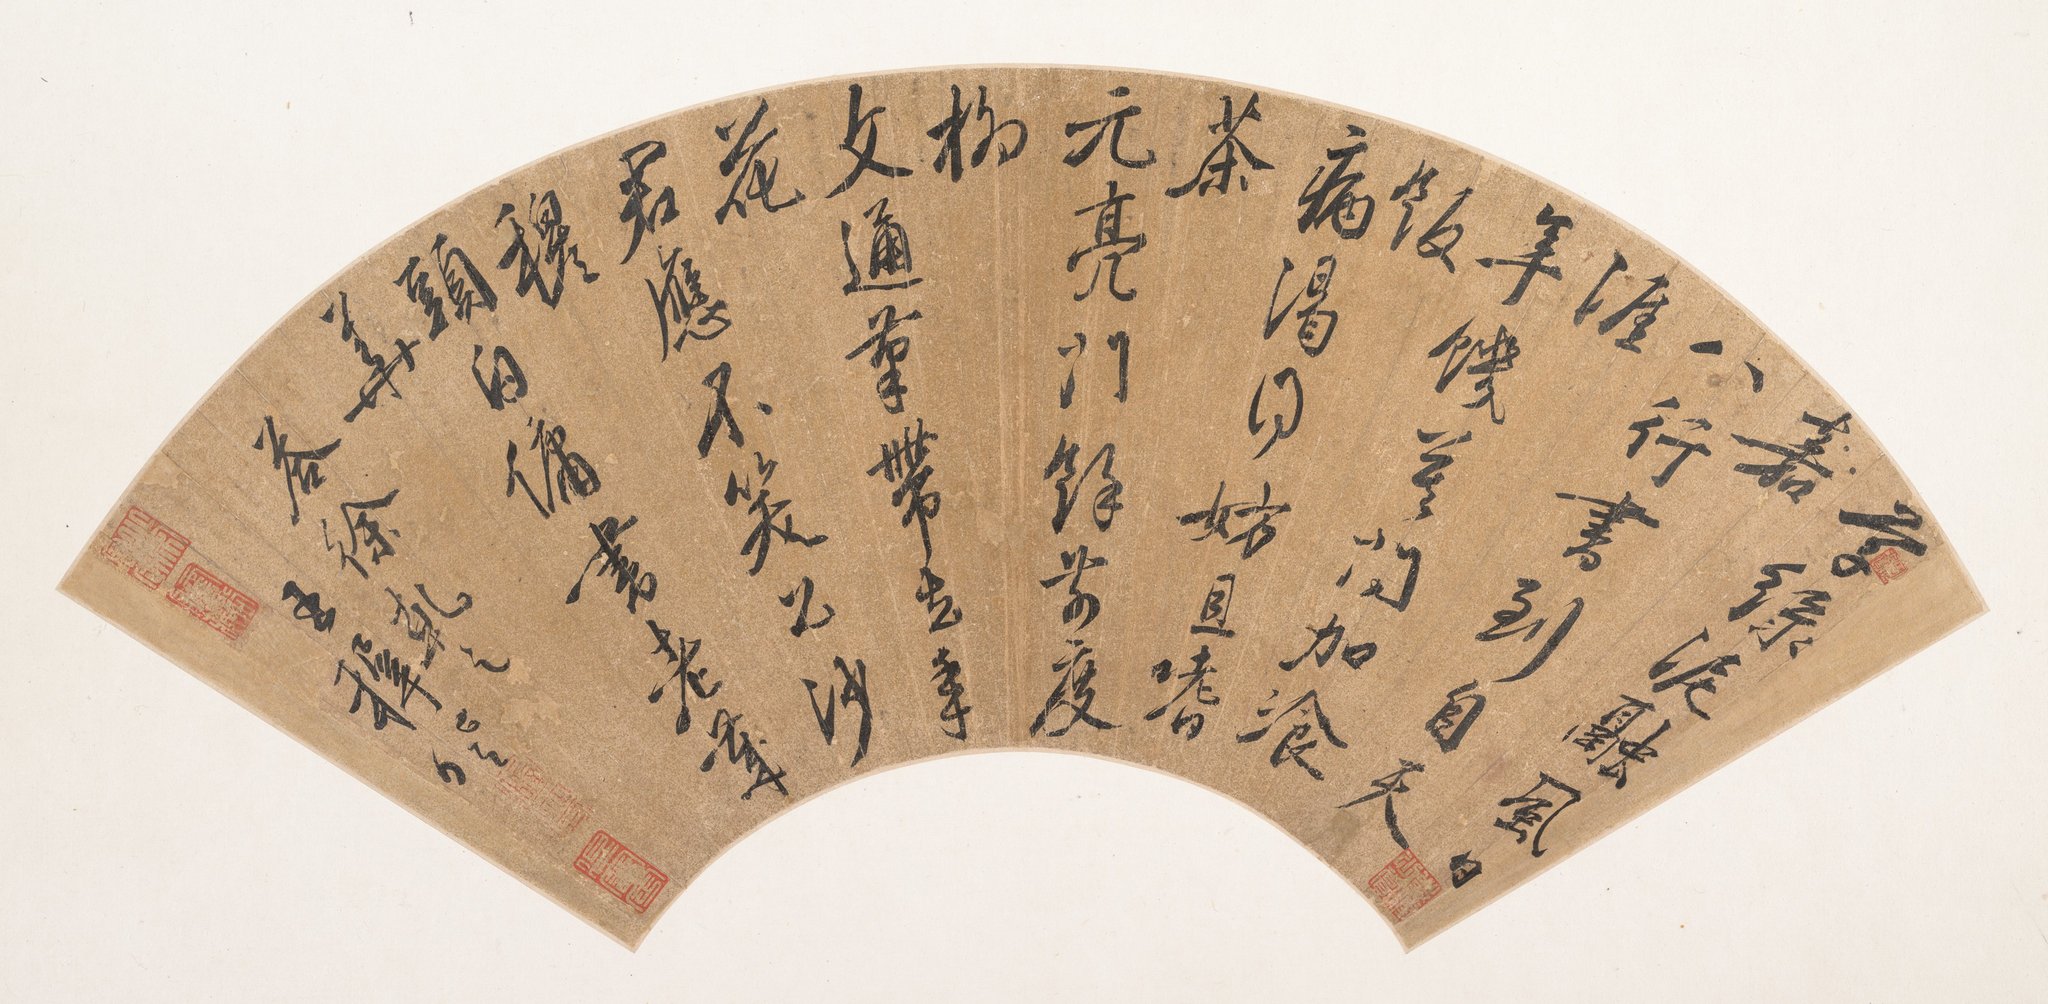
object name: folding fan mounted a an album leaf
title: Poem to Xu Qianzhi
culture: chinese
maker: wang zhideng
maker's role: artist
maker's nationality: chinese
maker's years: 1535-1612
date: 1535-1612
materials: gold, ink, paper